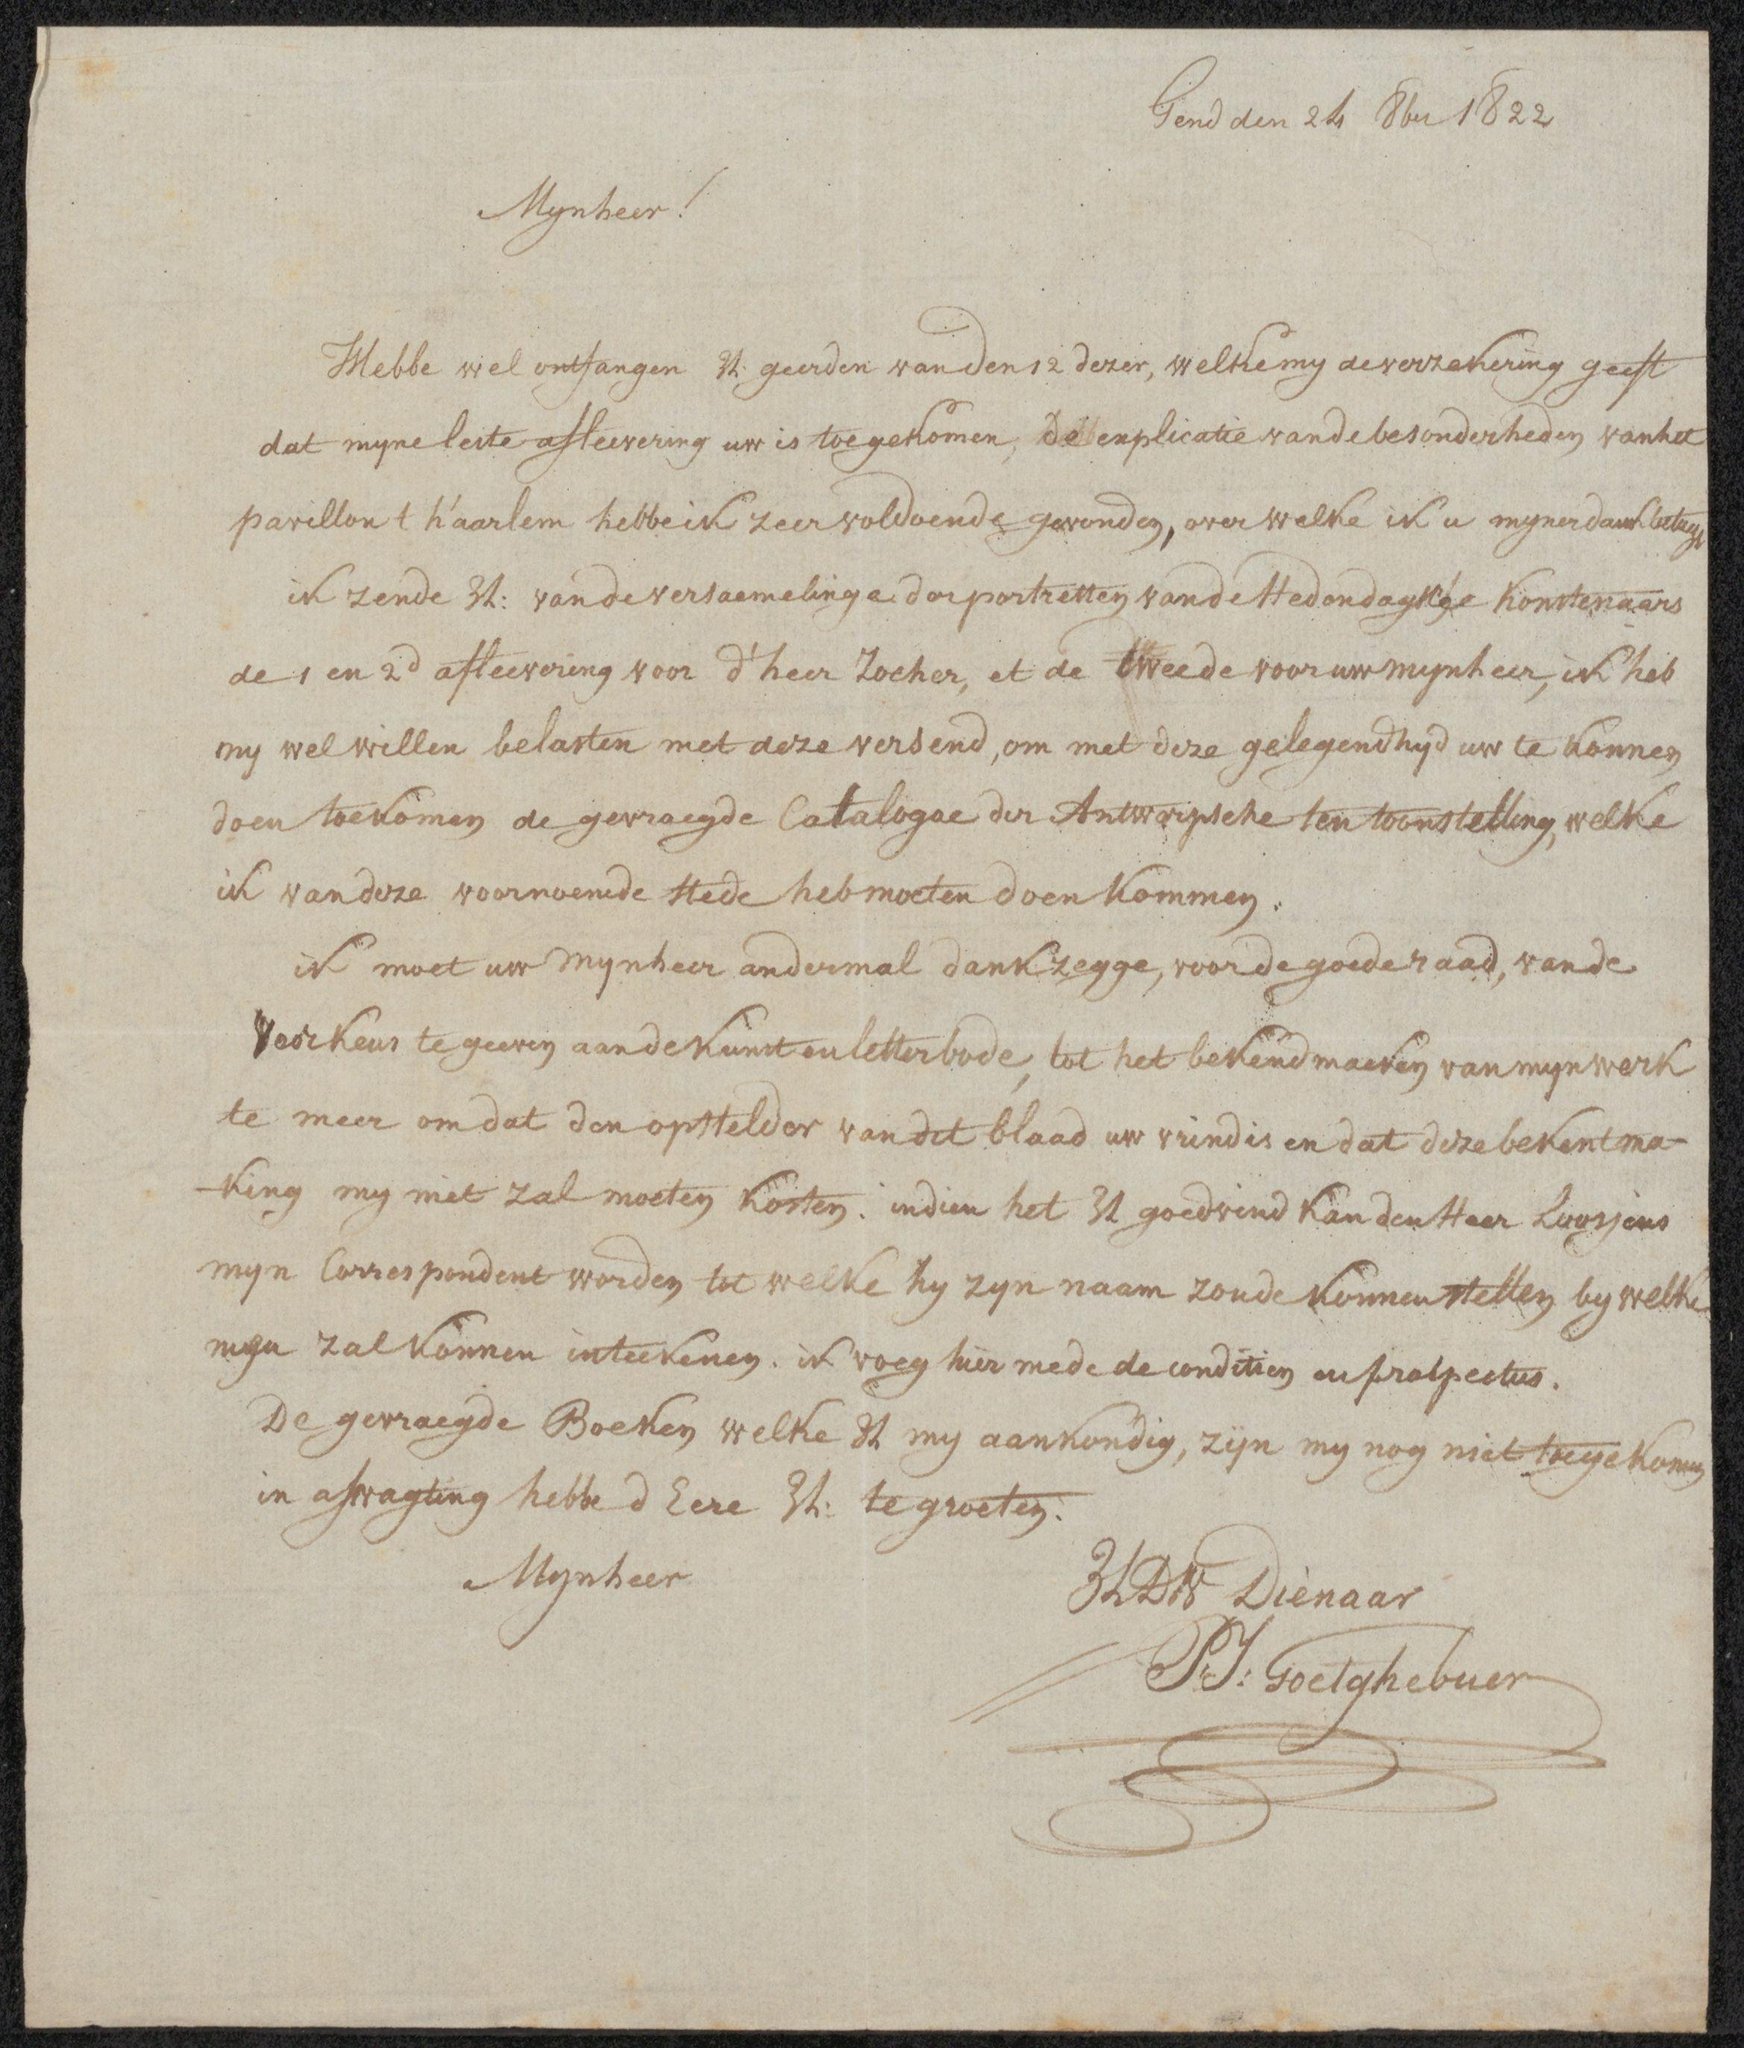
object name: letter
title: Brief aan Adriaan van der Willigen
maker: pierre jacques goetghebuer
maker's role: print maker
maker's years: 1788-1866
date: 1822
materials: ink, paper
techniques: pen, writing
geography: ghent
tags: rotterdam, draughtsman, adriaan van der willigen, haarlem, designer, johan david zocher, art collector, portrait, self-portrait of artist, exhibition ~ art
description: Naam van geadresseerde wordt niet genoemd, maar blijkt uit de inhoud van brieven van Goetghebuer aan Van der Willigen in andere collecties.